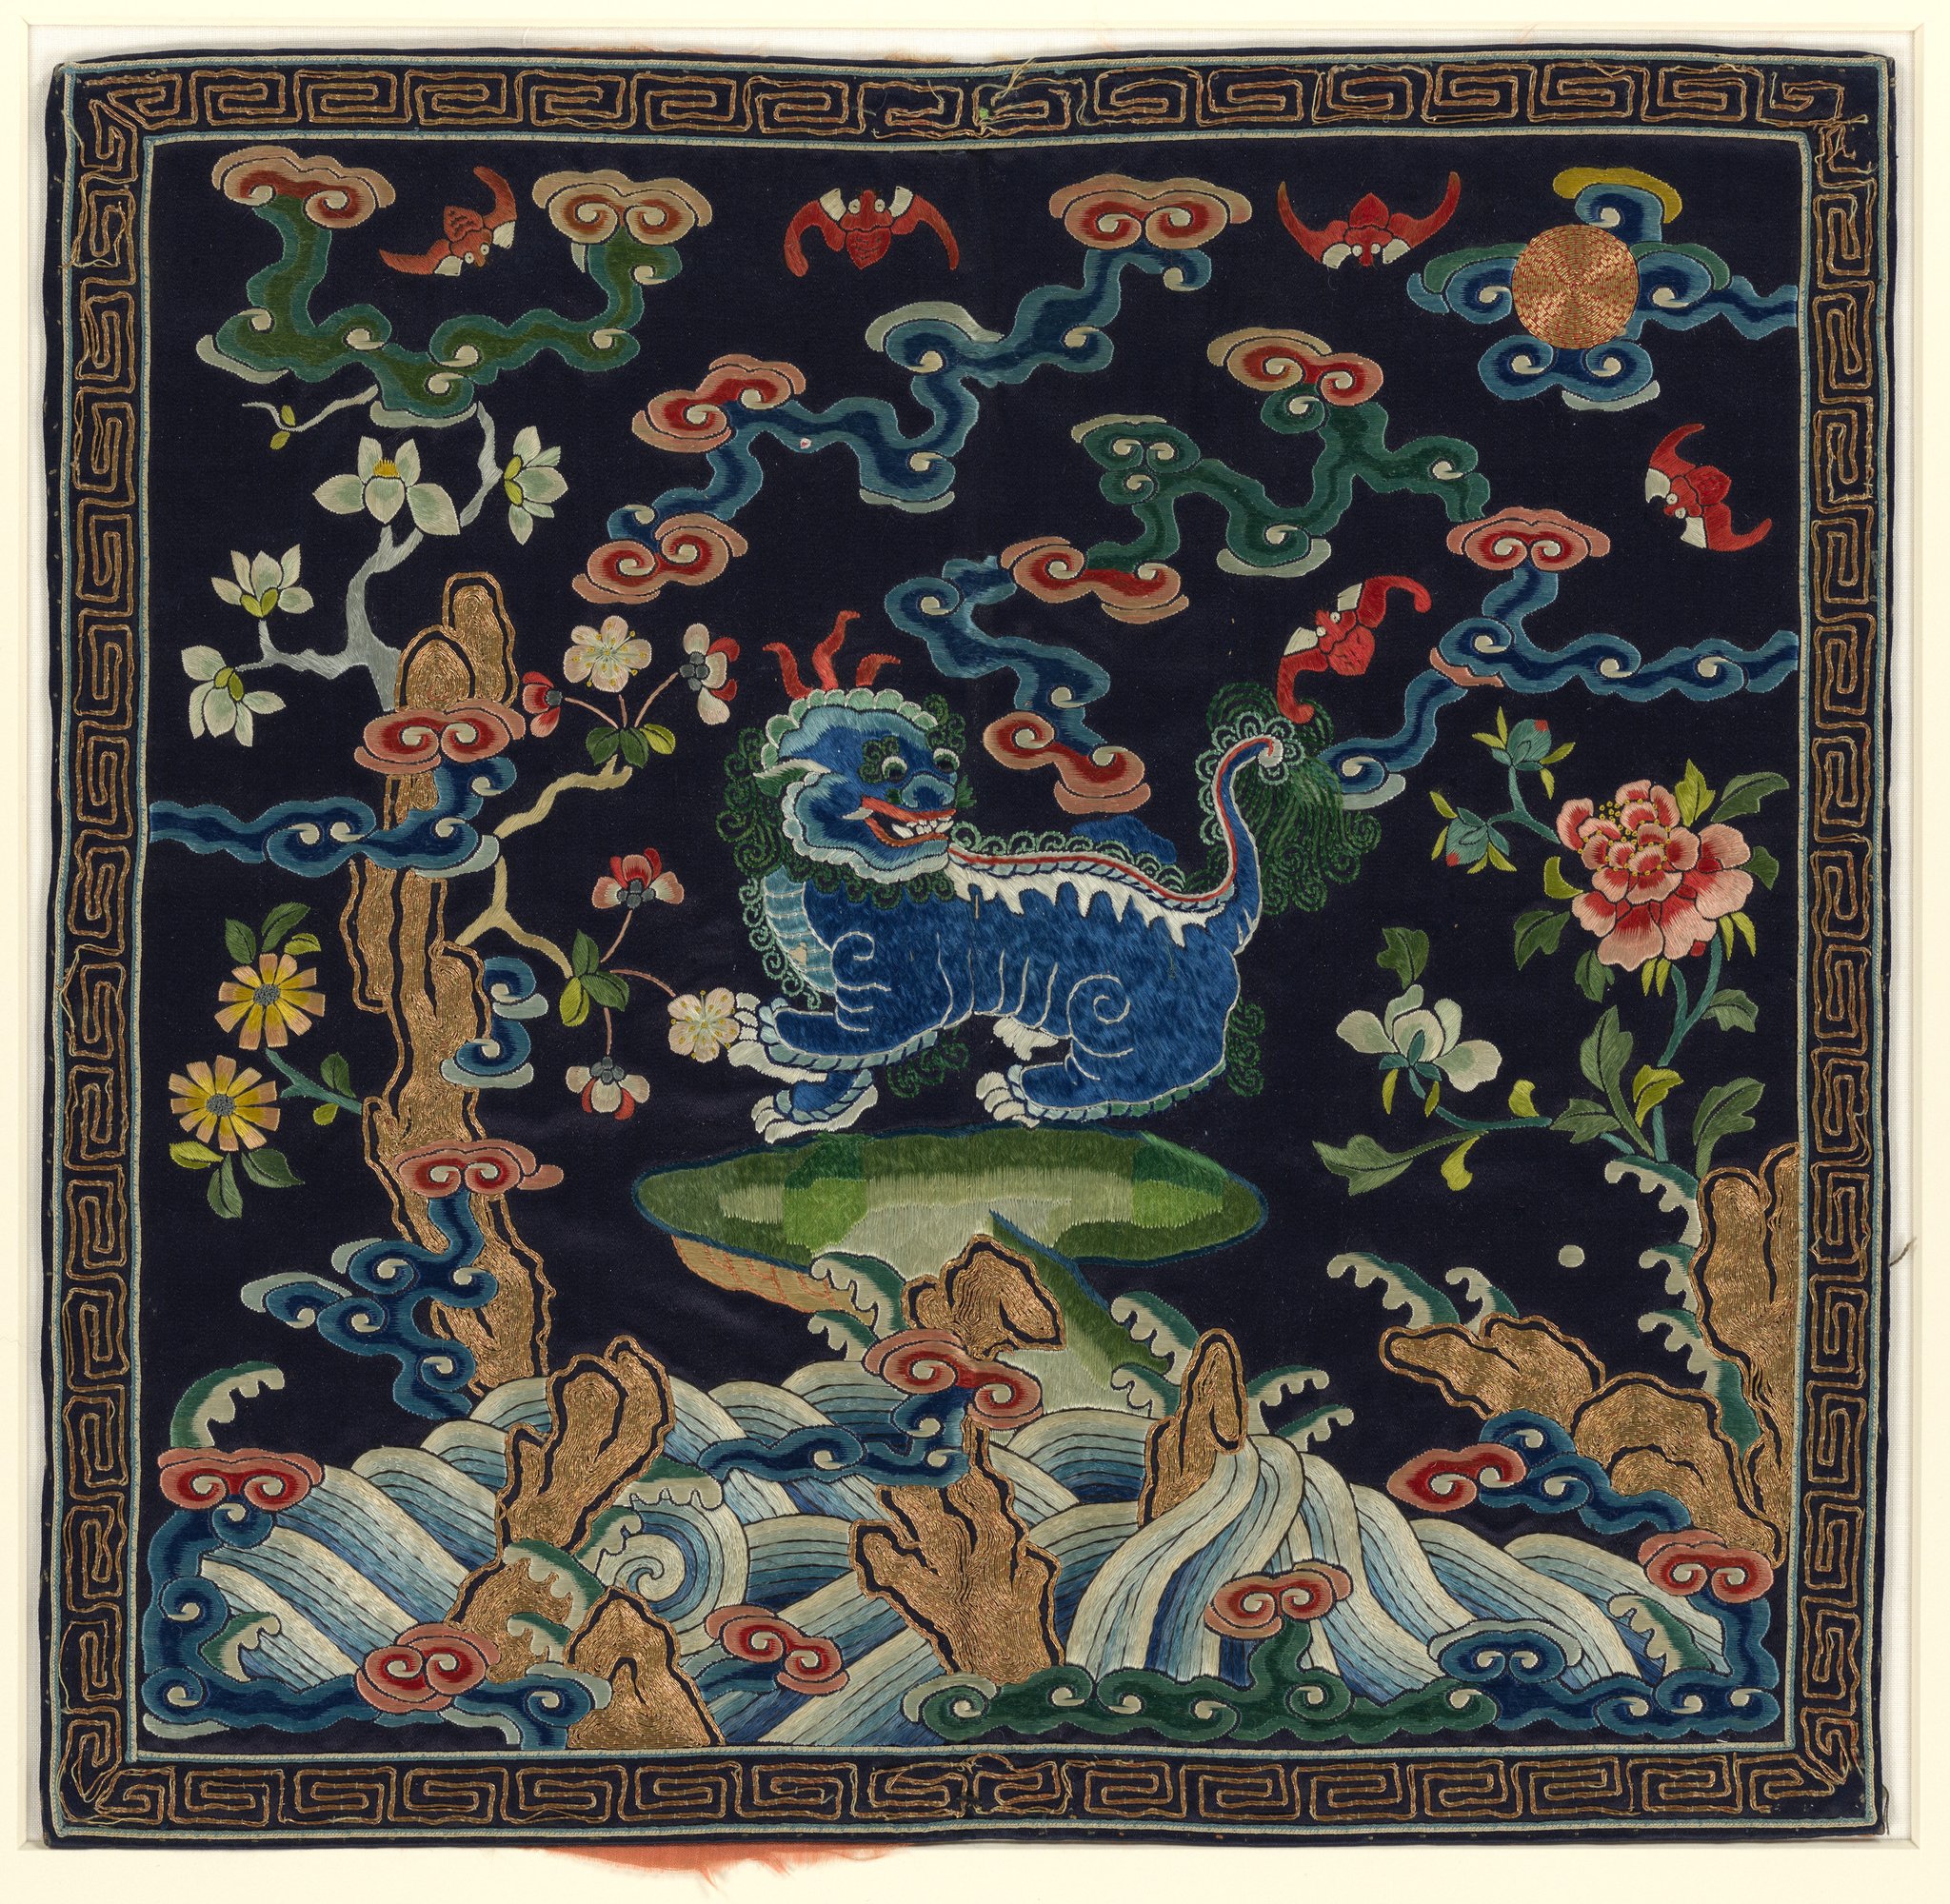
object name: rank badge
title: Rank badge with lion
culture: chinese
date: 1801-1900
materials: metal thread, silk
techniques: embroidery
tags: bats,lions